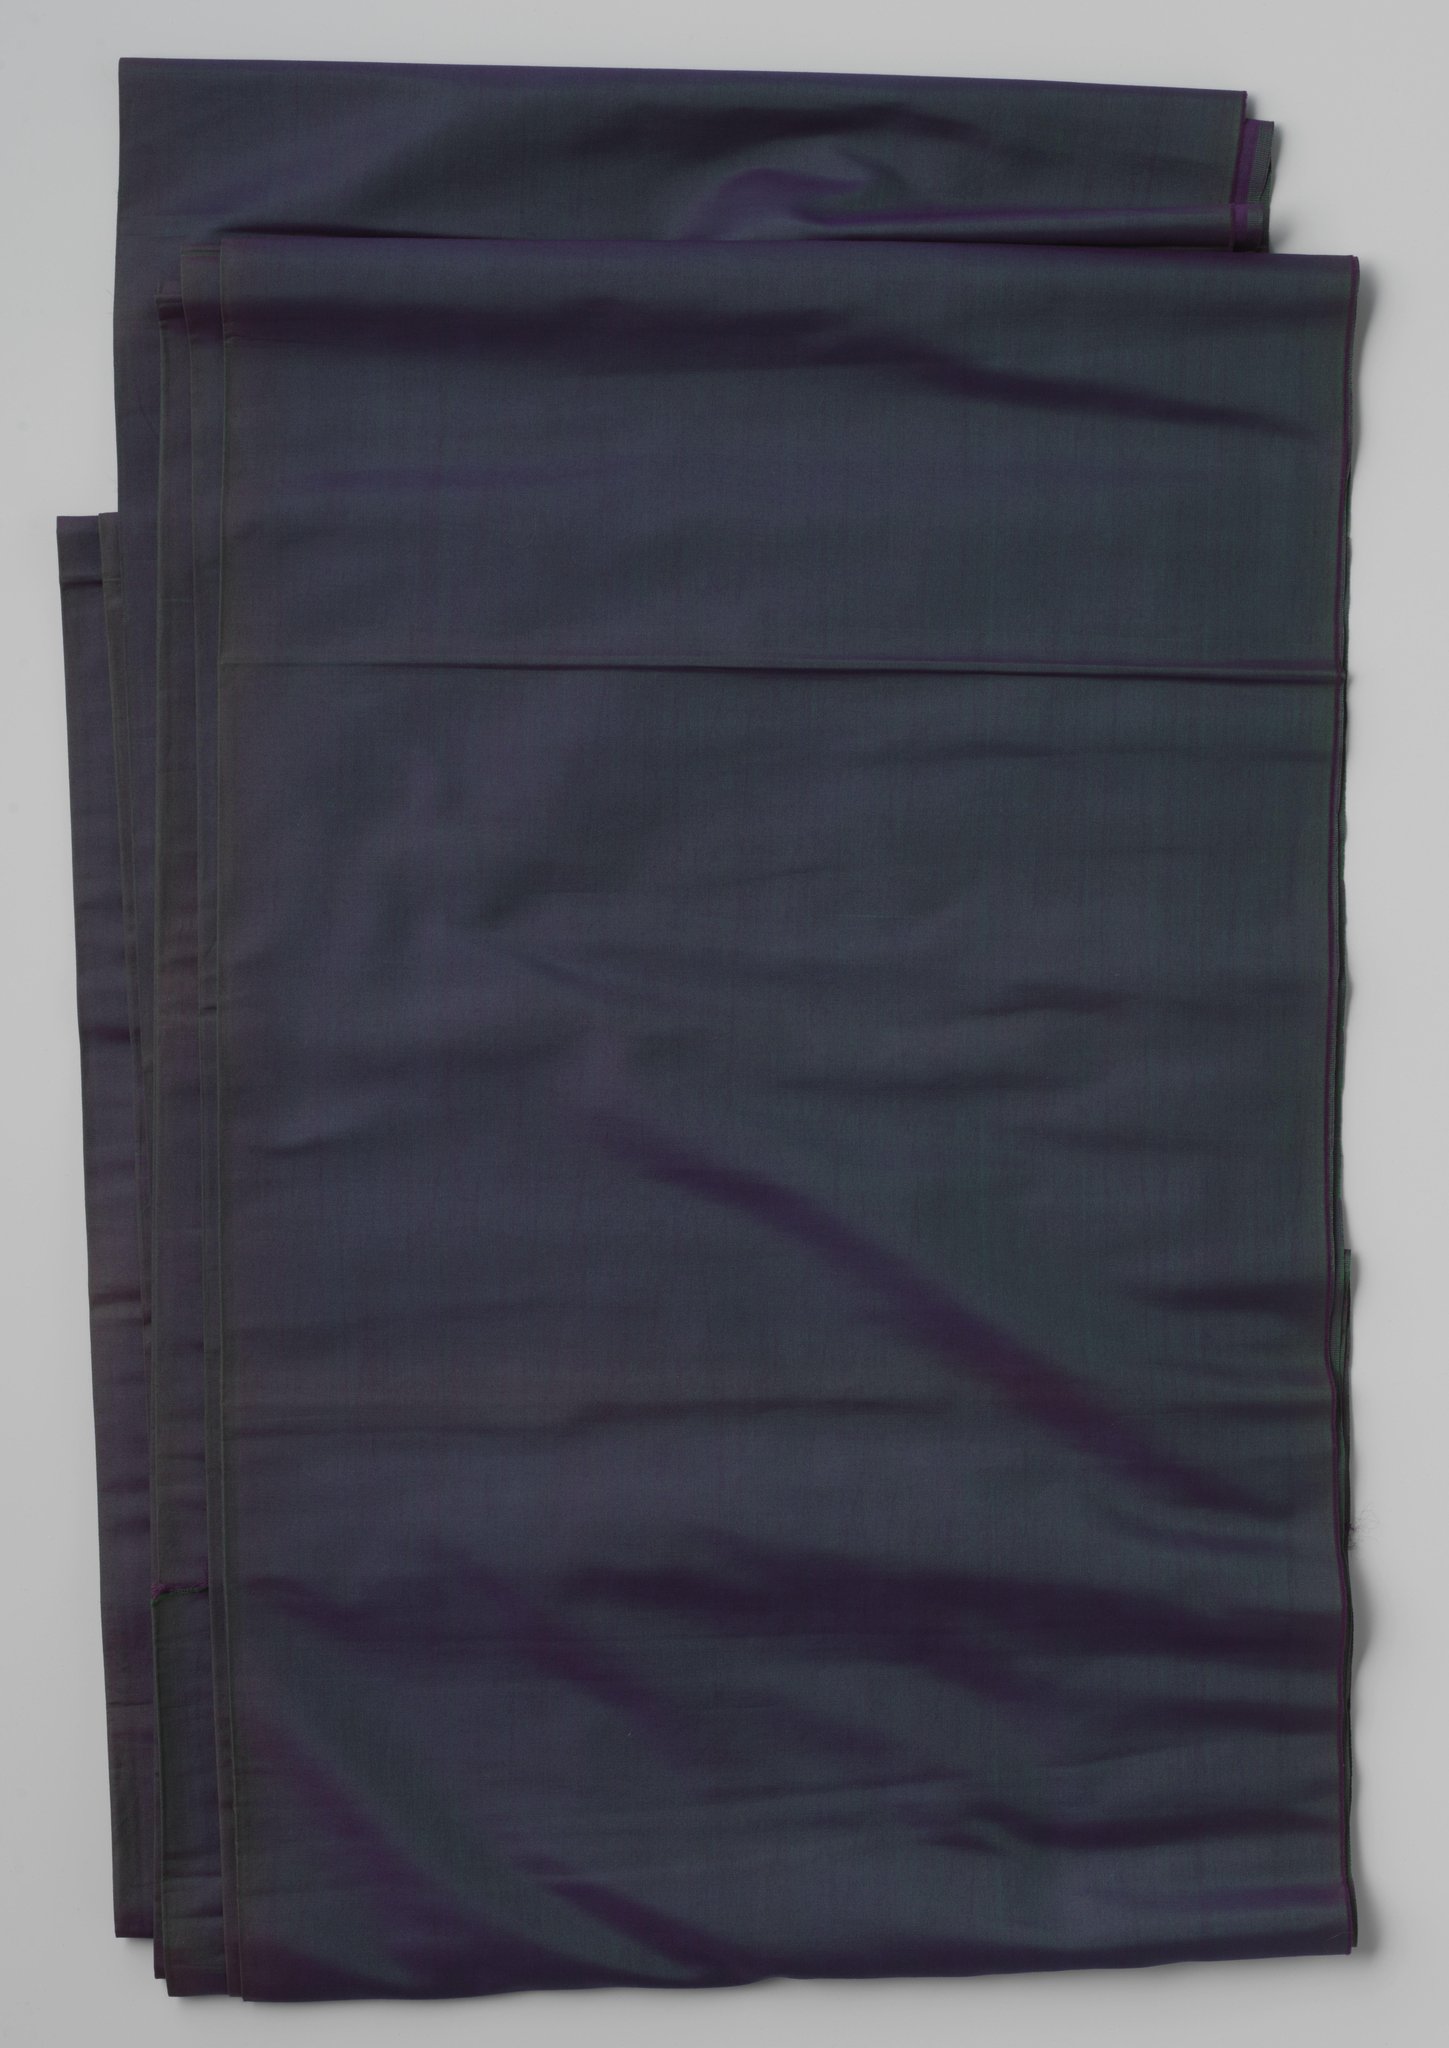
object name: coupon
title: Coupon van weerschijntafzijde in paars-groen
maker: gustav schnitzler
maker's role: paraplufabrikant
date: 1900-1950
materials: silk, textile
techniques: weave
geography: nijmegen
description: Metrage parapluiezijde. Van weerschijntafzijde in paars/groen.